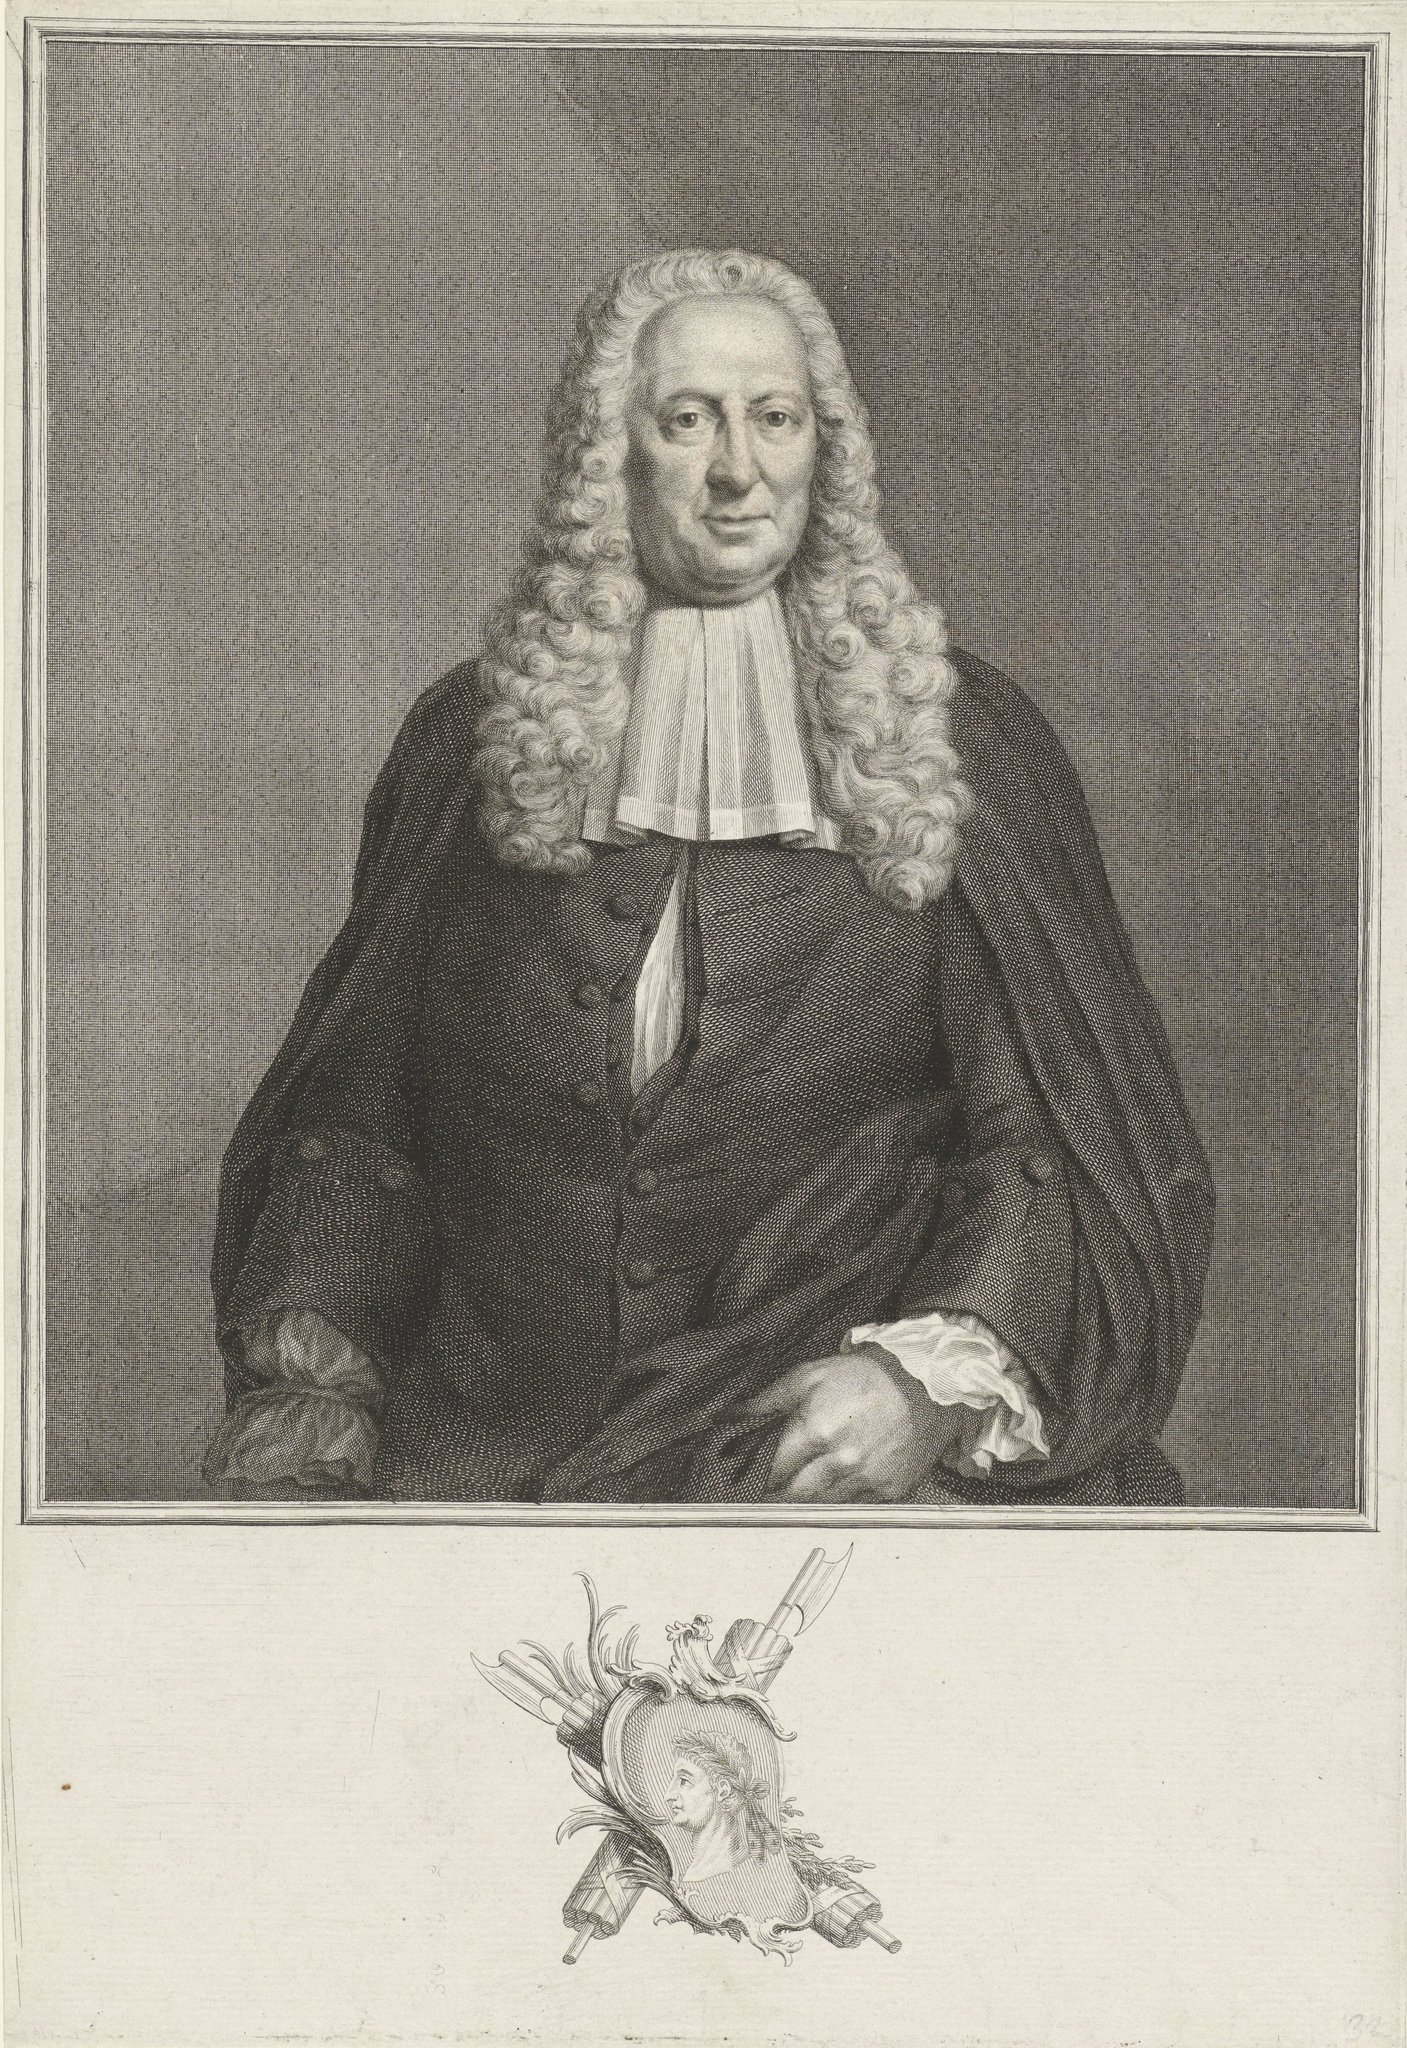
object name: print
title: Portret van Gerrit Hooft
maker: jacob houbraken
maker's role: draughtsman, print maker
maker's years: 1698-1780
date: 1758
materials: paper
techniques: engraving, etching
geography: amsterdam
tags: amsterdam, mayor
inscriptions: collector's mark: Lugt 2228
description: Portret ten halven lijve van Gerrit Hooft. Onder het portret een cartouche met een gelauwerde kop en profil naar links met daarachter twee fasces.